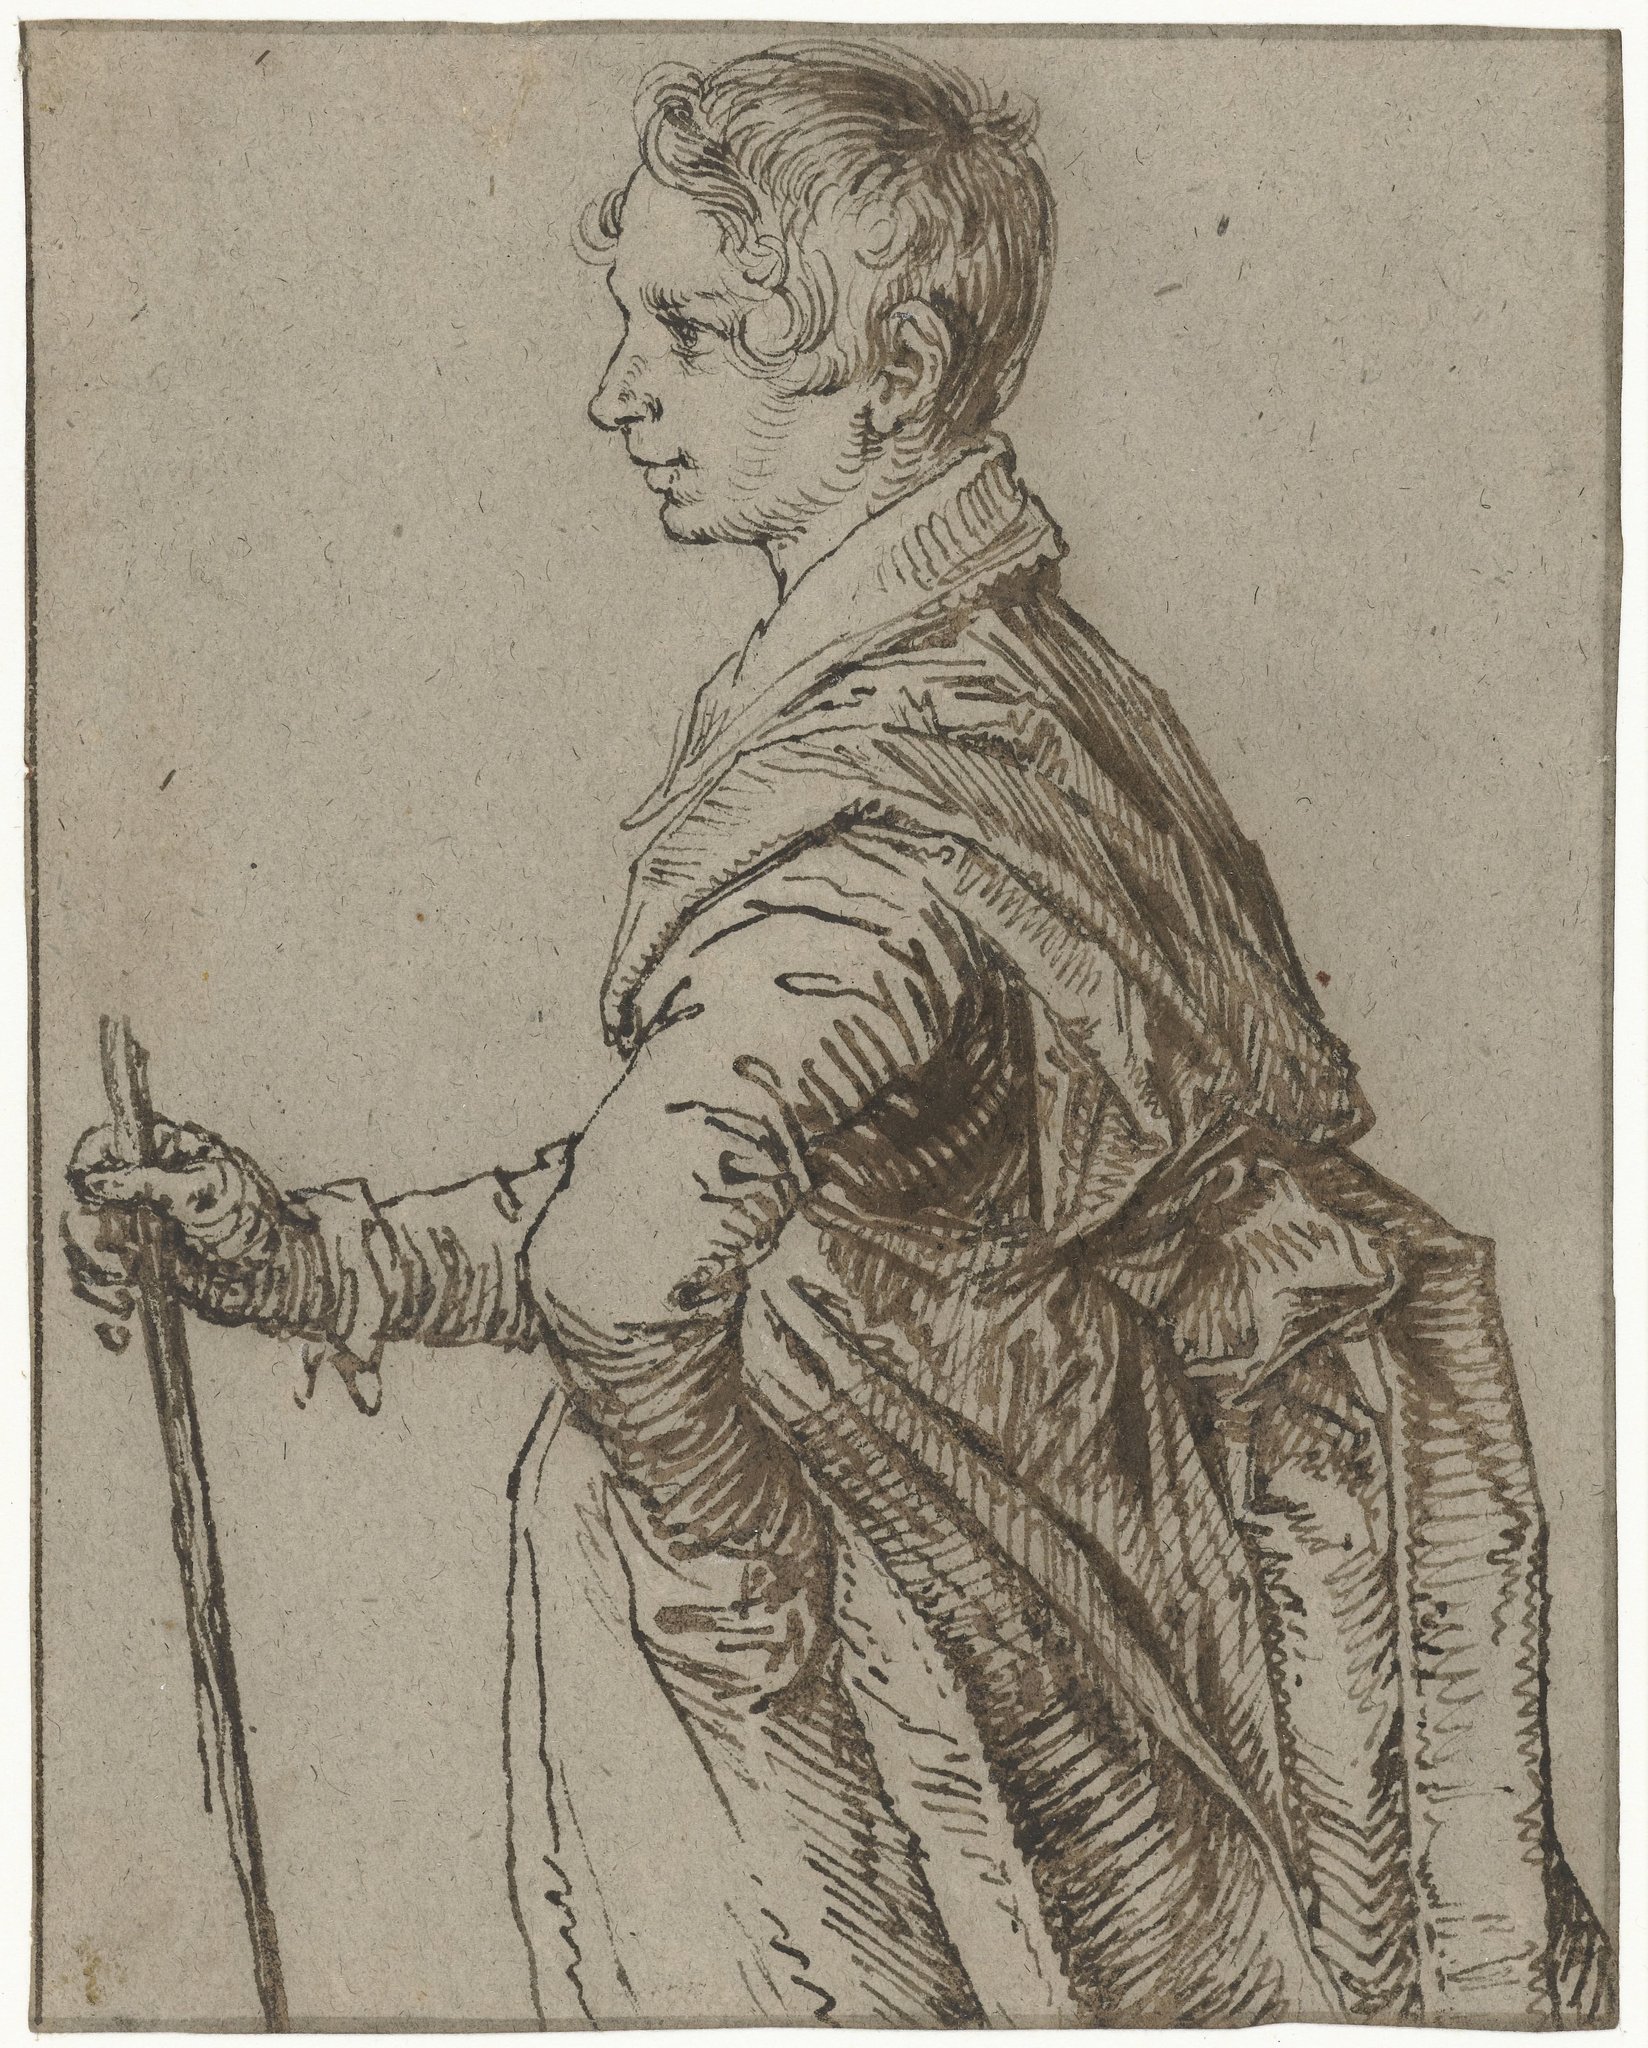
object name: drawing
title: Young man standing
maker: jacques de gheyn (ii)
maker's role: painter, print maker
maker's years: 1565-1629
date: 1598-1608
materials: ink, paper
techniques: pen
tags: standing figure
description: This young man was probably once part of a larger drawing. Art dealers often cut such sheets into pieces and sold them as separate studies for a greater profit. This sheet was unfortunately reduced at the lower edge, leaving the boy legless!